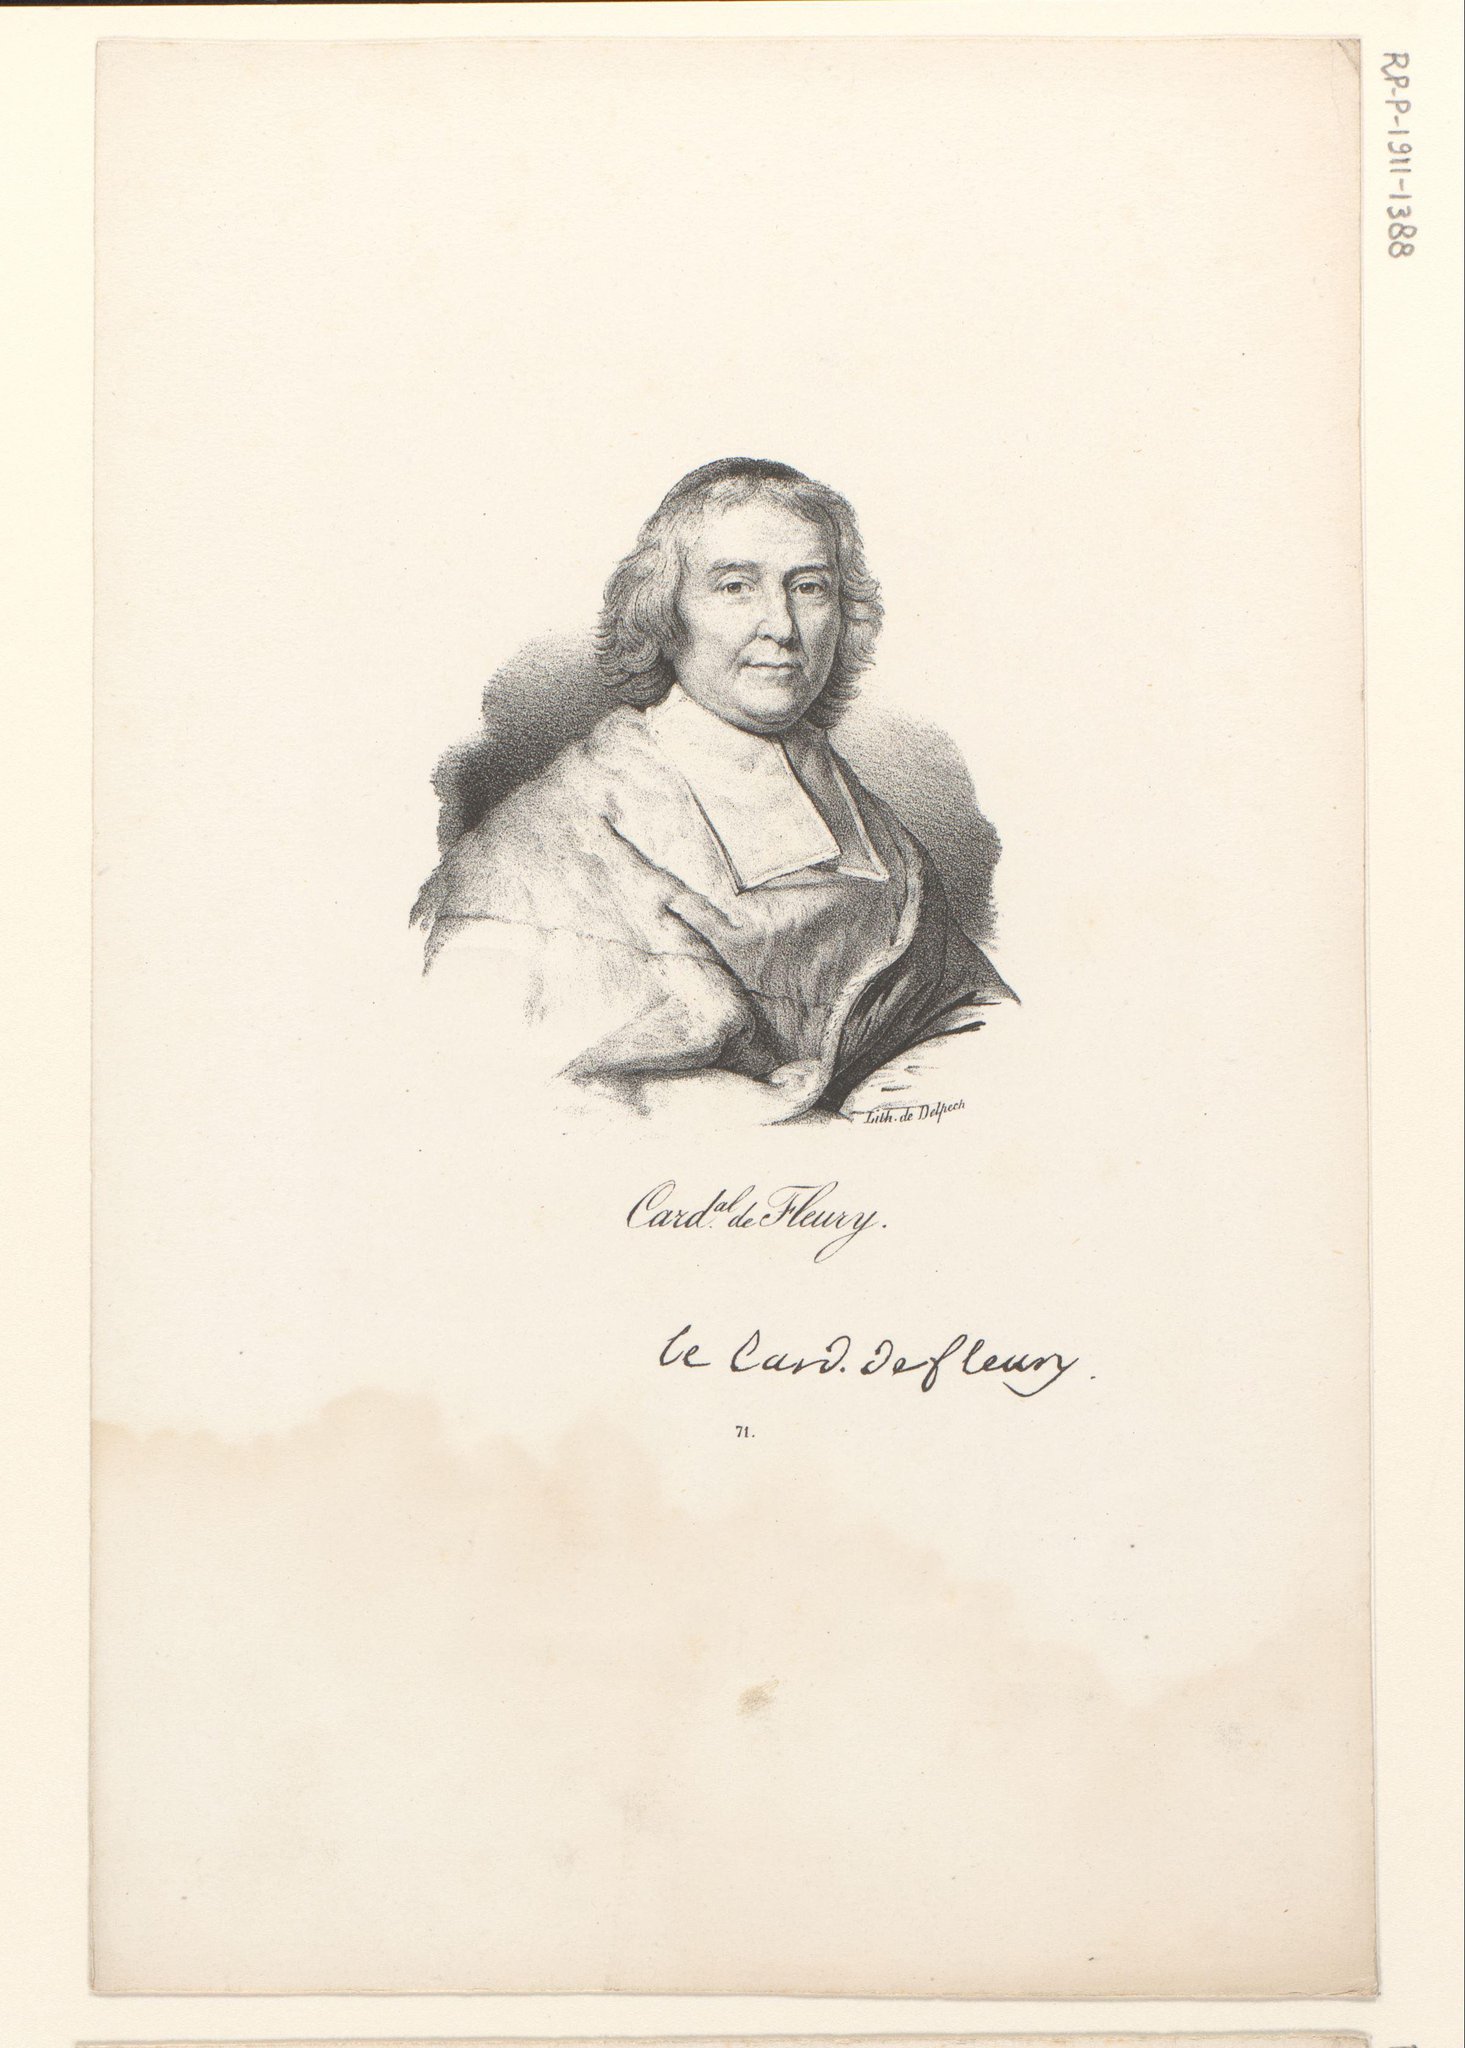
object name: print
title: Portret van Pierre-François-Léonard Fontaine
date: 1818-1842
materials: paper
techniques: lithograph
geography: paris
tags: pierre-françois-léonard fontaine, historical persons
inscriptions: collector's mark: Lugt 2228a